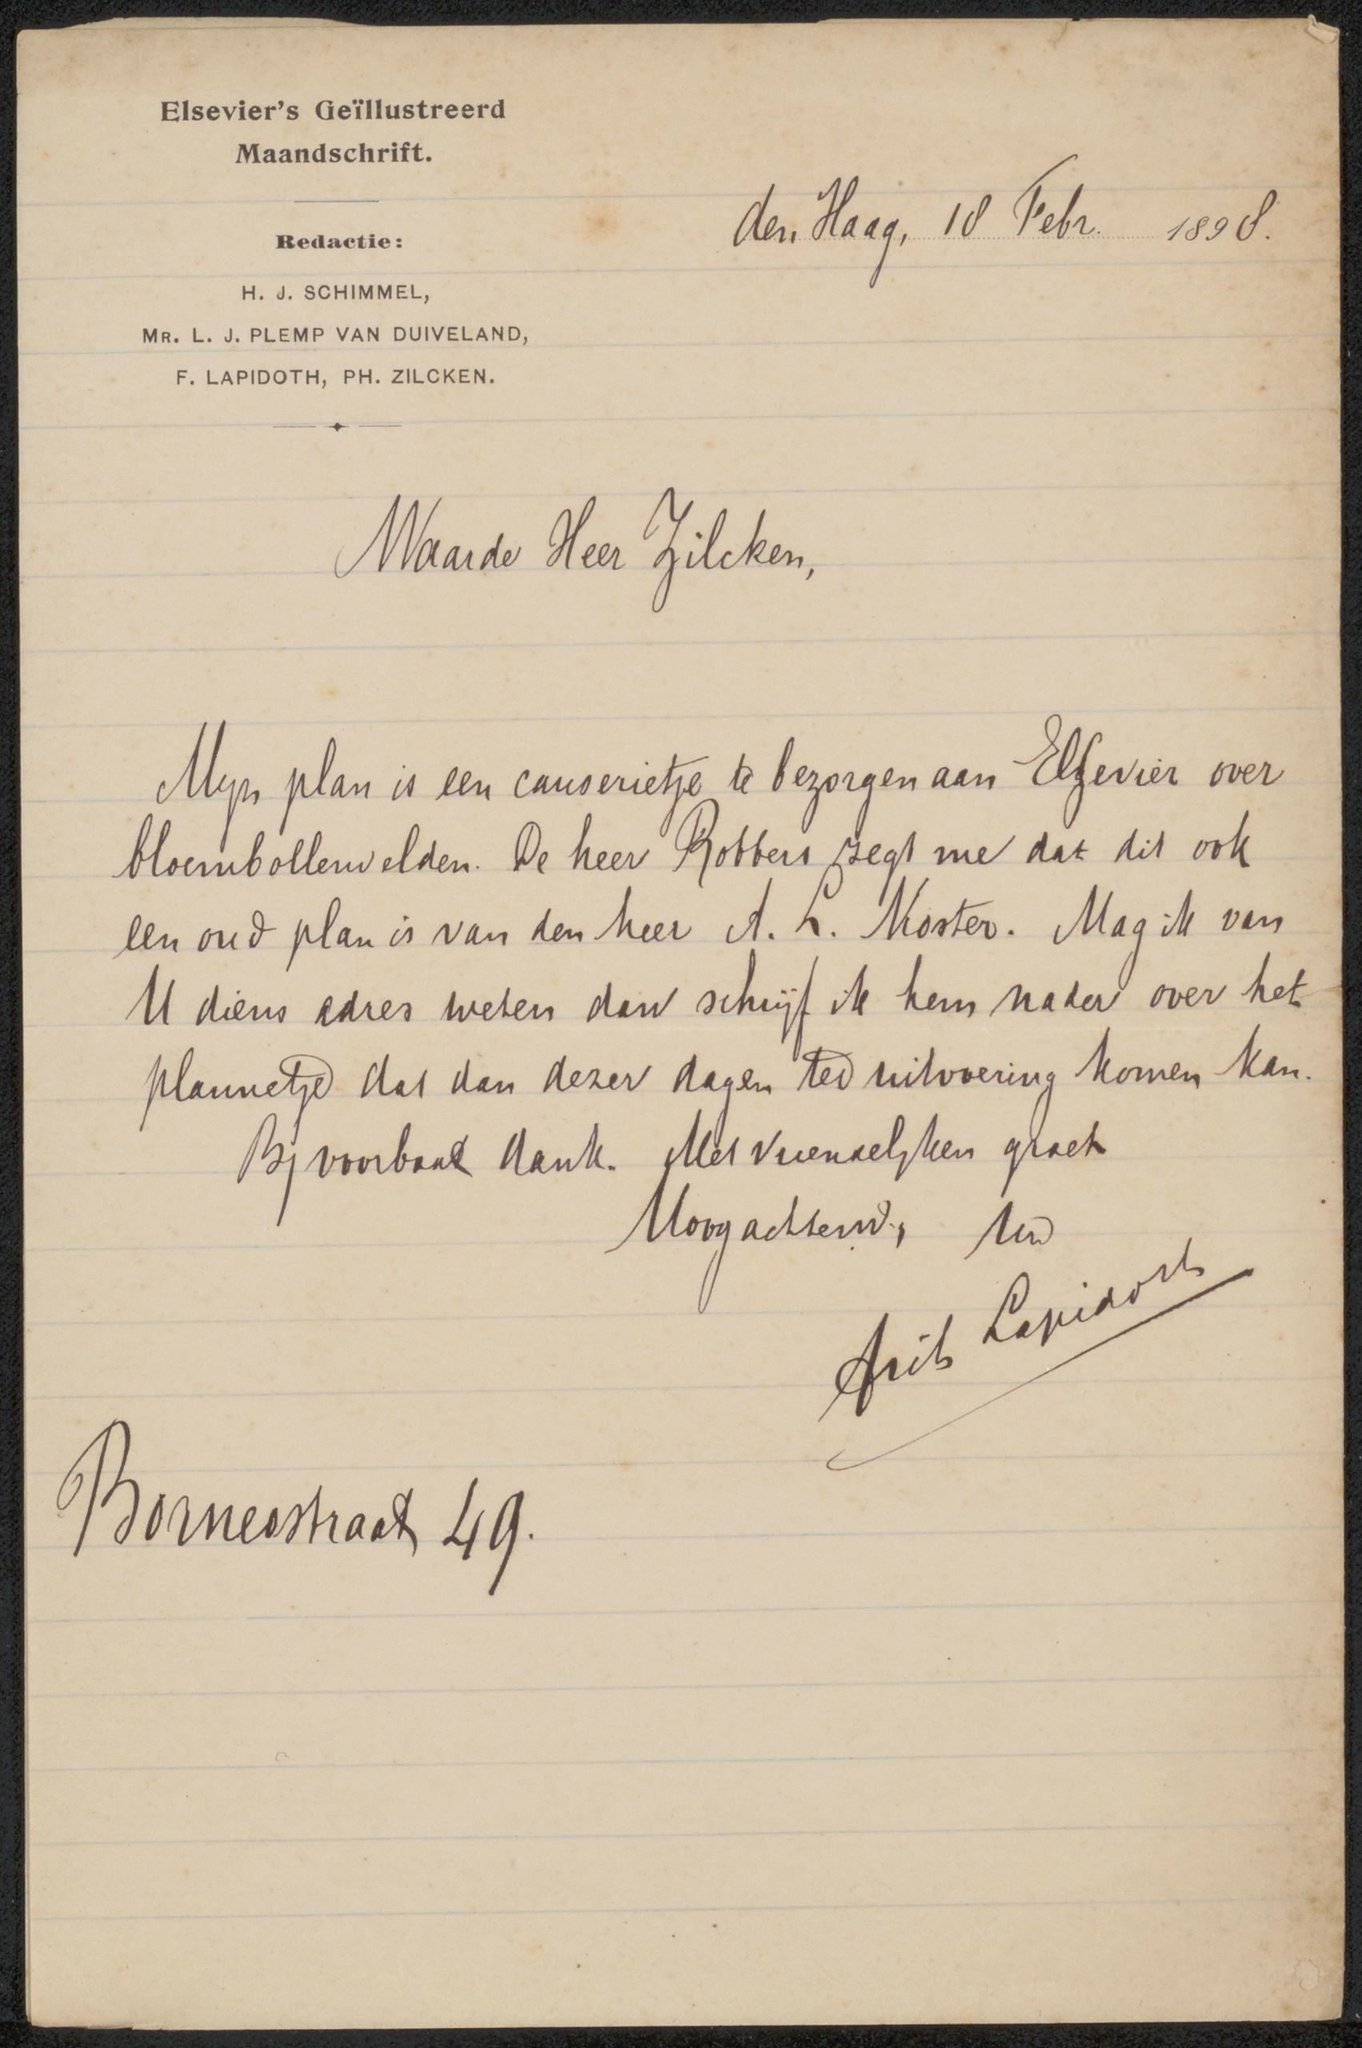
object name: letter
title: Brief aan Philip Zilcken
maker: frits lapidoth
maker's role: schrijver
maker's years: 1861-1932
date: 1898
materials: ink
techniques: pen, printing, writing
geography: the hague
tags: painter, draughtsman, philip zilcken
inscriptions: collector's mark: ‘RPK’